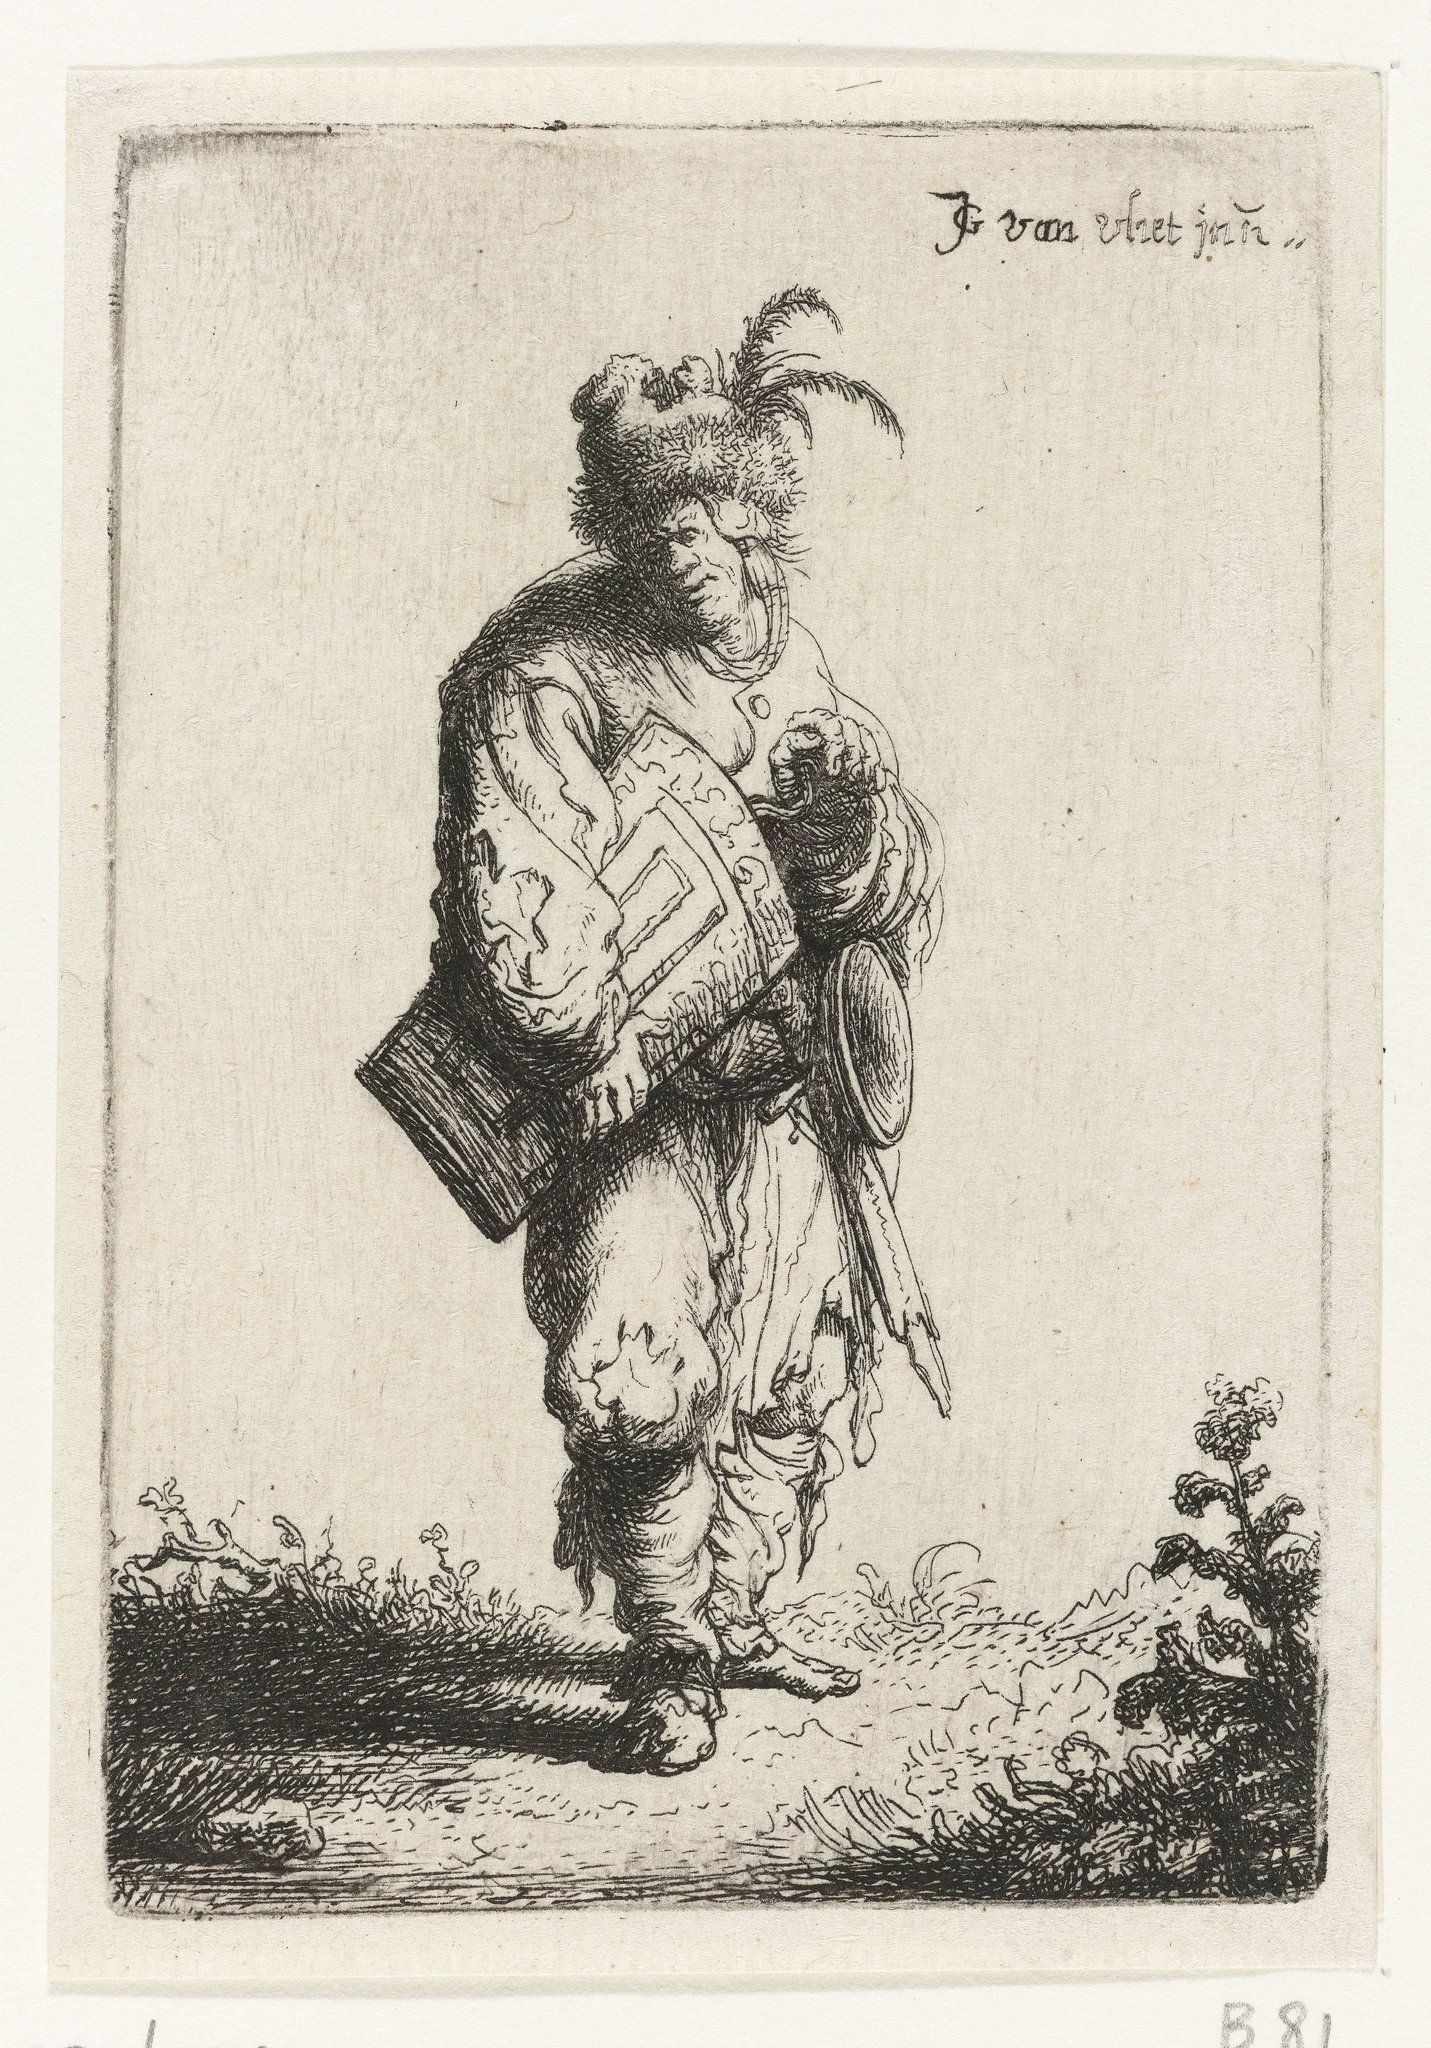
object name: print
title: Bedelaars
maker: jan gillisz. van vliet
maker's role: draughtsman, painter, print maker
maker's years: 1600-1668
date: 1632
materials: paper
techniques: etching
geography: leiden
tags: hurdy-gurdy player - cc - out of doors, beggar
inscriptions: collector's mark: Lugt 240